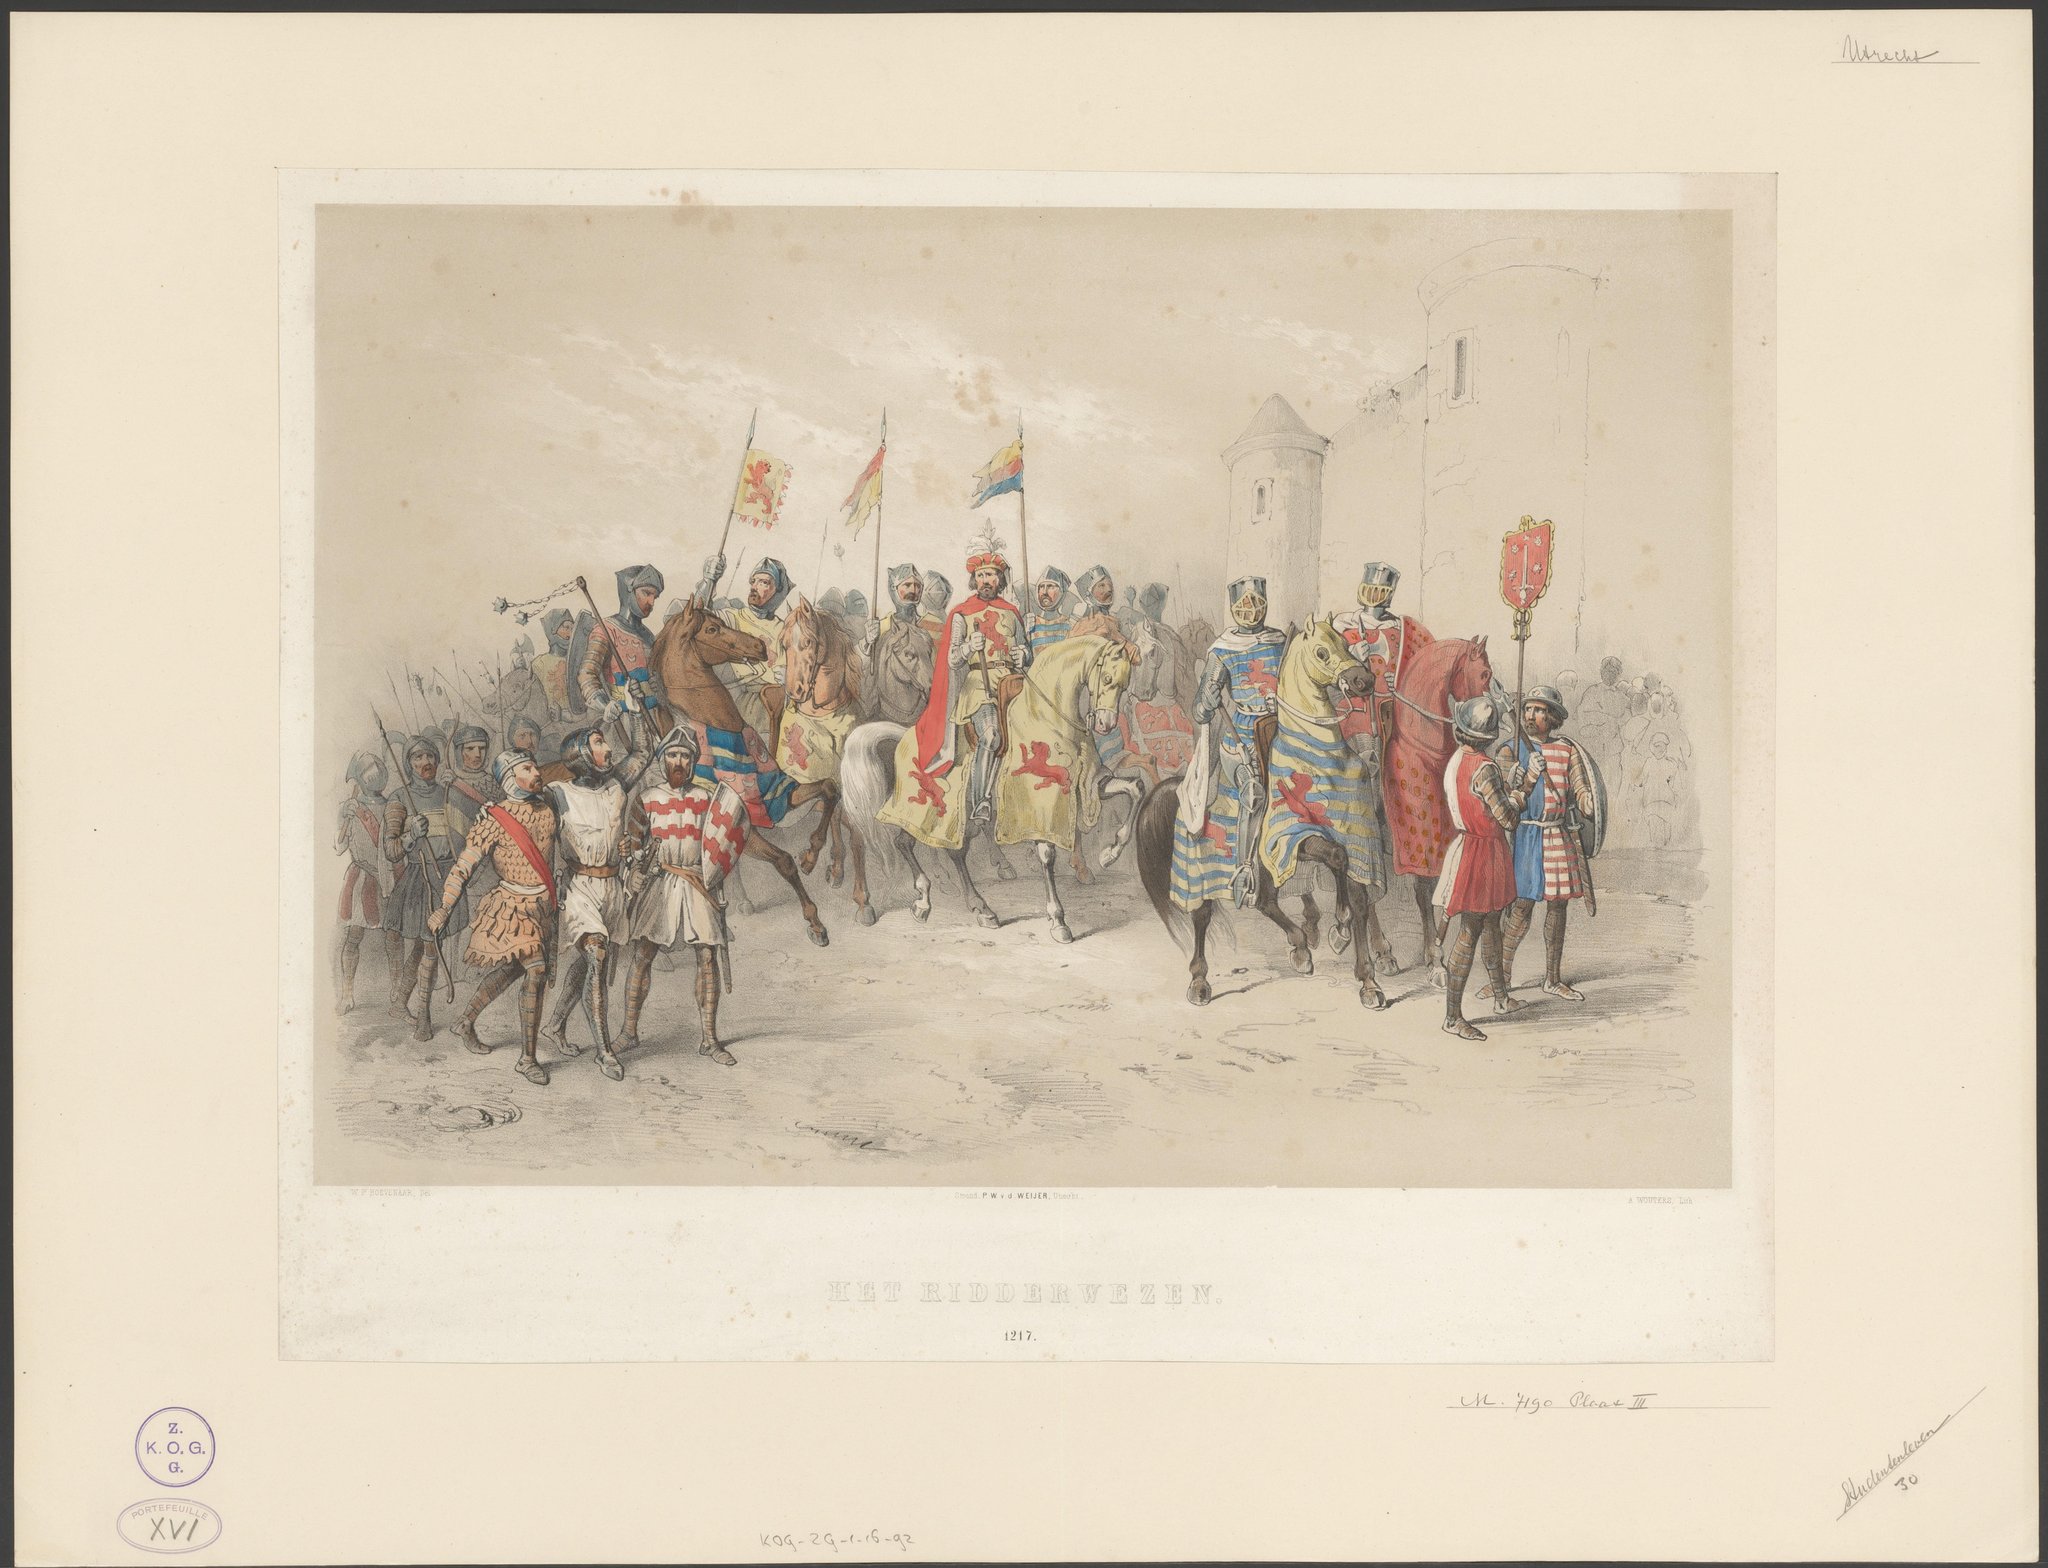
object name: print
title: Utrechtse maskerade van 1851: Ridderwezen, 1217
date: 1851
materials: paper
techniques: hand coloring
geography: utrecht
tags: students' pageant, costumes used in pageants, utrecht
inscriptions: stamp, collector's mark: Lugt 1641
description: Prent uit een serie van acht prenten en acht zangen van de maskerade van de Utrechtse studenten, 25 juni 1851. De maskerade verbeeldt in taferelen acht episodes uit de vaderlandse geschiedenis.